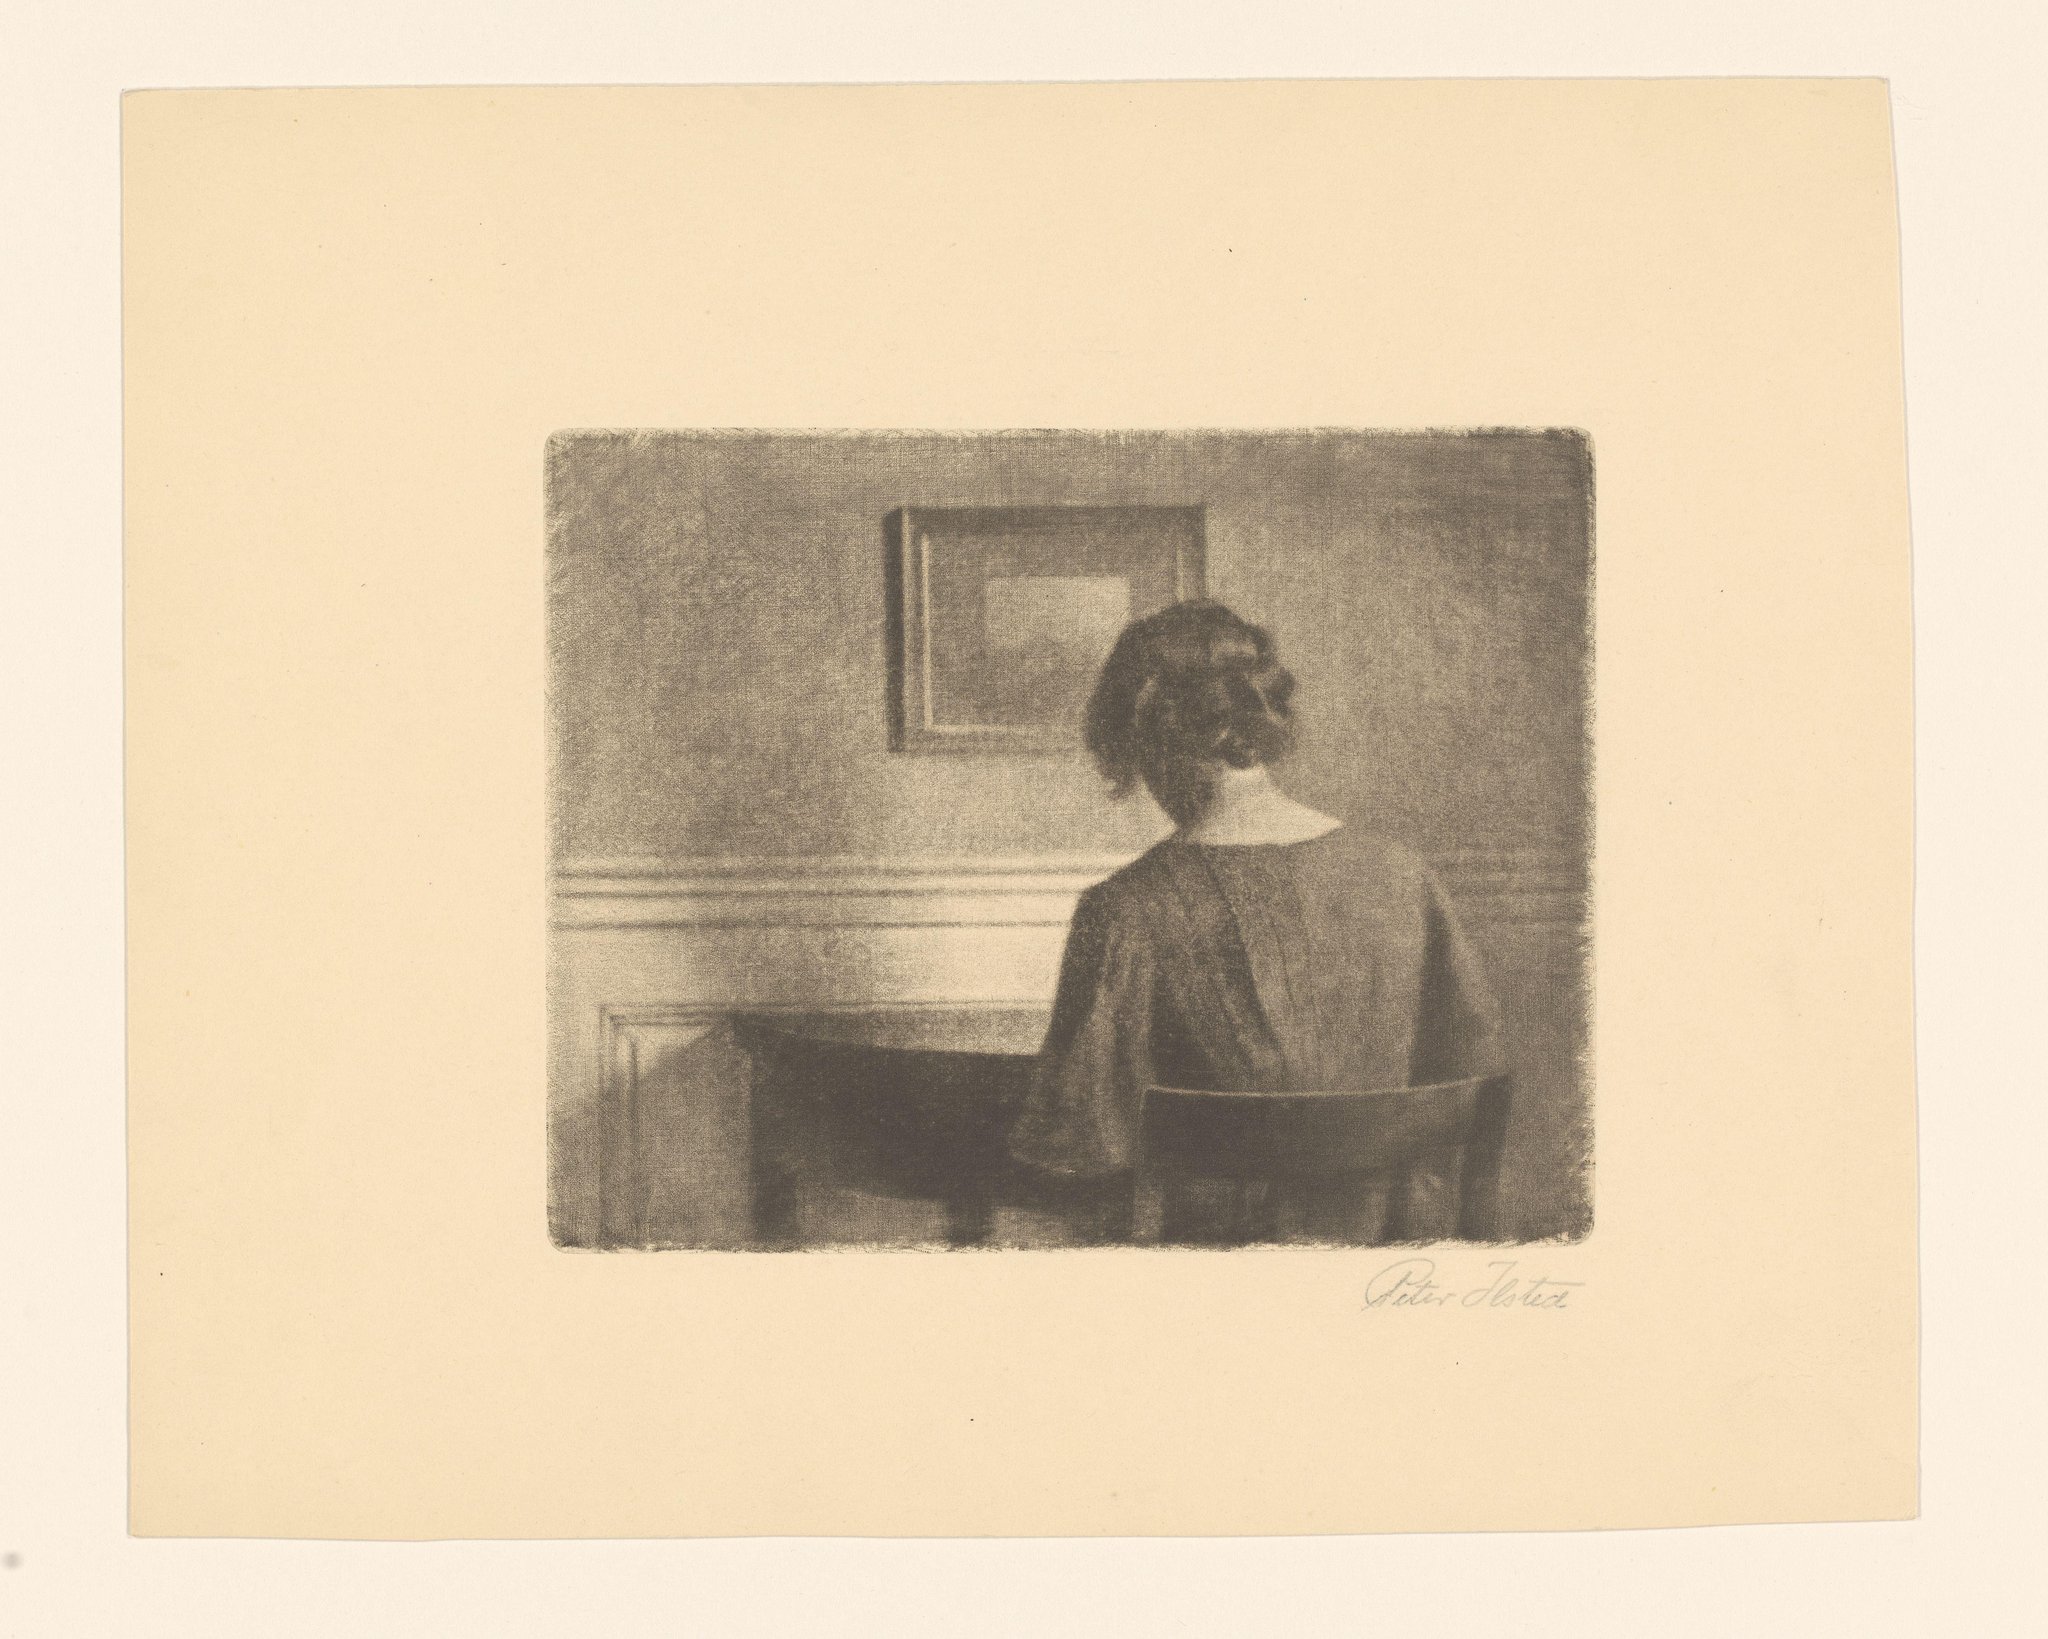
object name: print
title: Meisje aan een halfronde tafel.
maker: peter vilhelm ilsted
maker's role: print maker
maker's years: 1861-1933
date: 1909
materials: paper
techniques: mezzotint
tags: adolescent, young woman, maiden, table, living-room, parlour, sitting-room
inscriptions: collector's mark: Lugt 2760, collector's mark: Lugt 2228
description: Jong meisje, van achteren gezien, zittend aan een halfronde tafel.